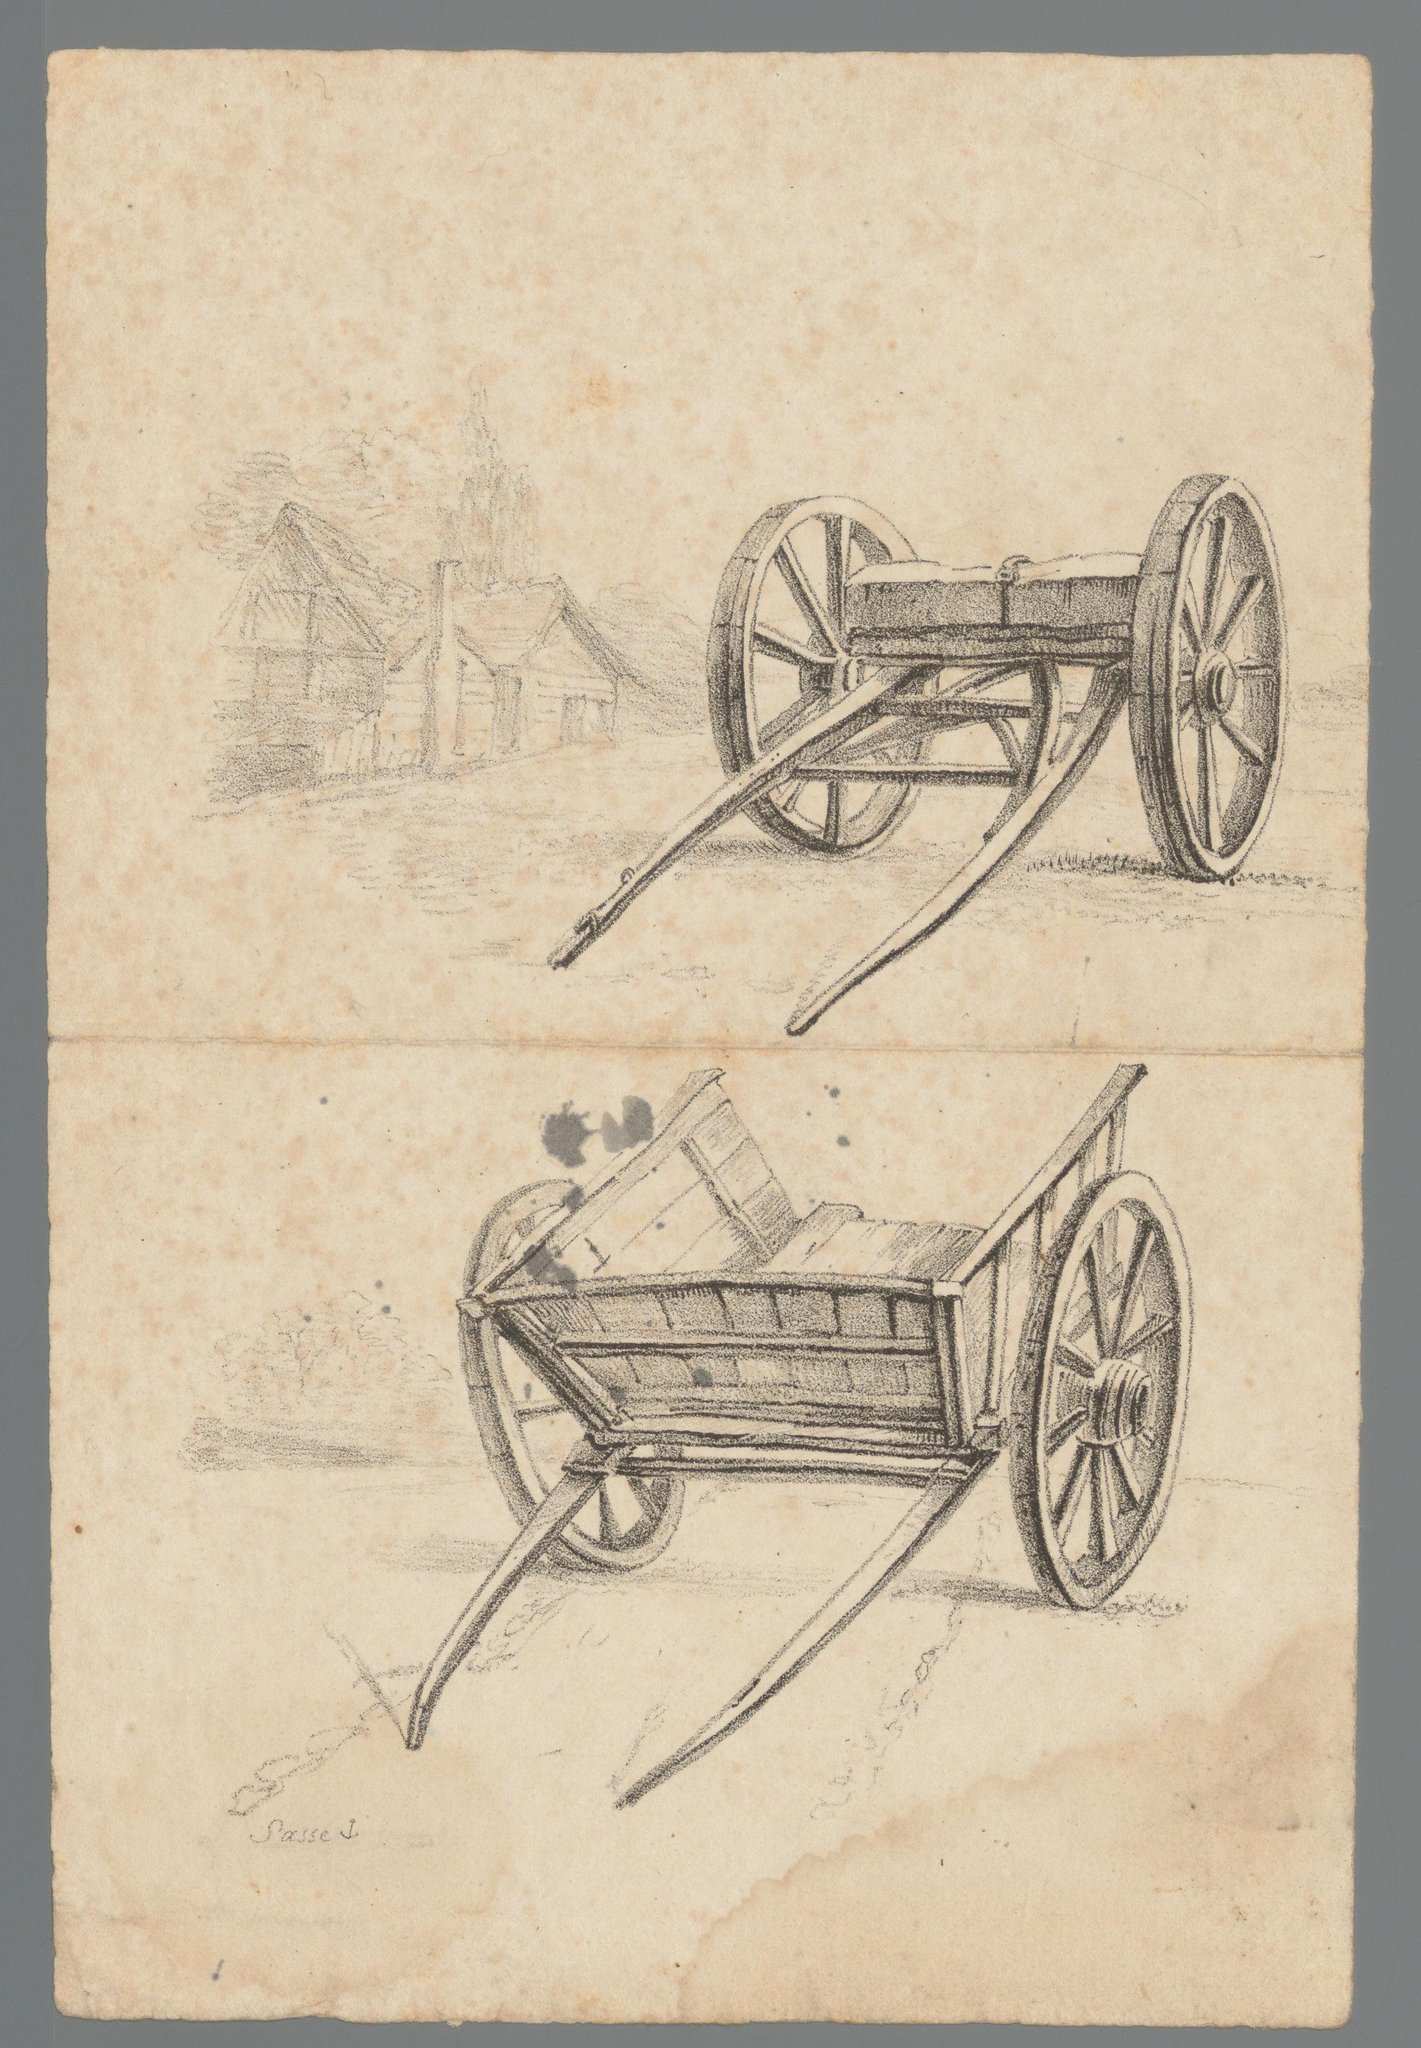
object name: print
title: Twee studies van een kar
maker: richard sasse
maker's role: print maker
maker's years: 1774-1849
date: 1800-1849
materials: paper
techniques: lithograph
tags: traffic on land, two-wheeled, animal-drawn vehicle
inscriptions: collector's mark: Lugt 2228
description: Prent behoort tot de serie 'L'art de dessiner le paysage d'apres nature'. Deze serie is in tien delen met elk zes lithografieën uitgegeven.